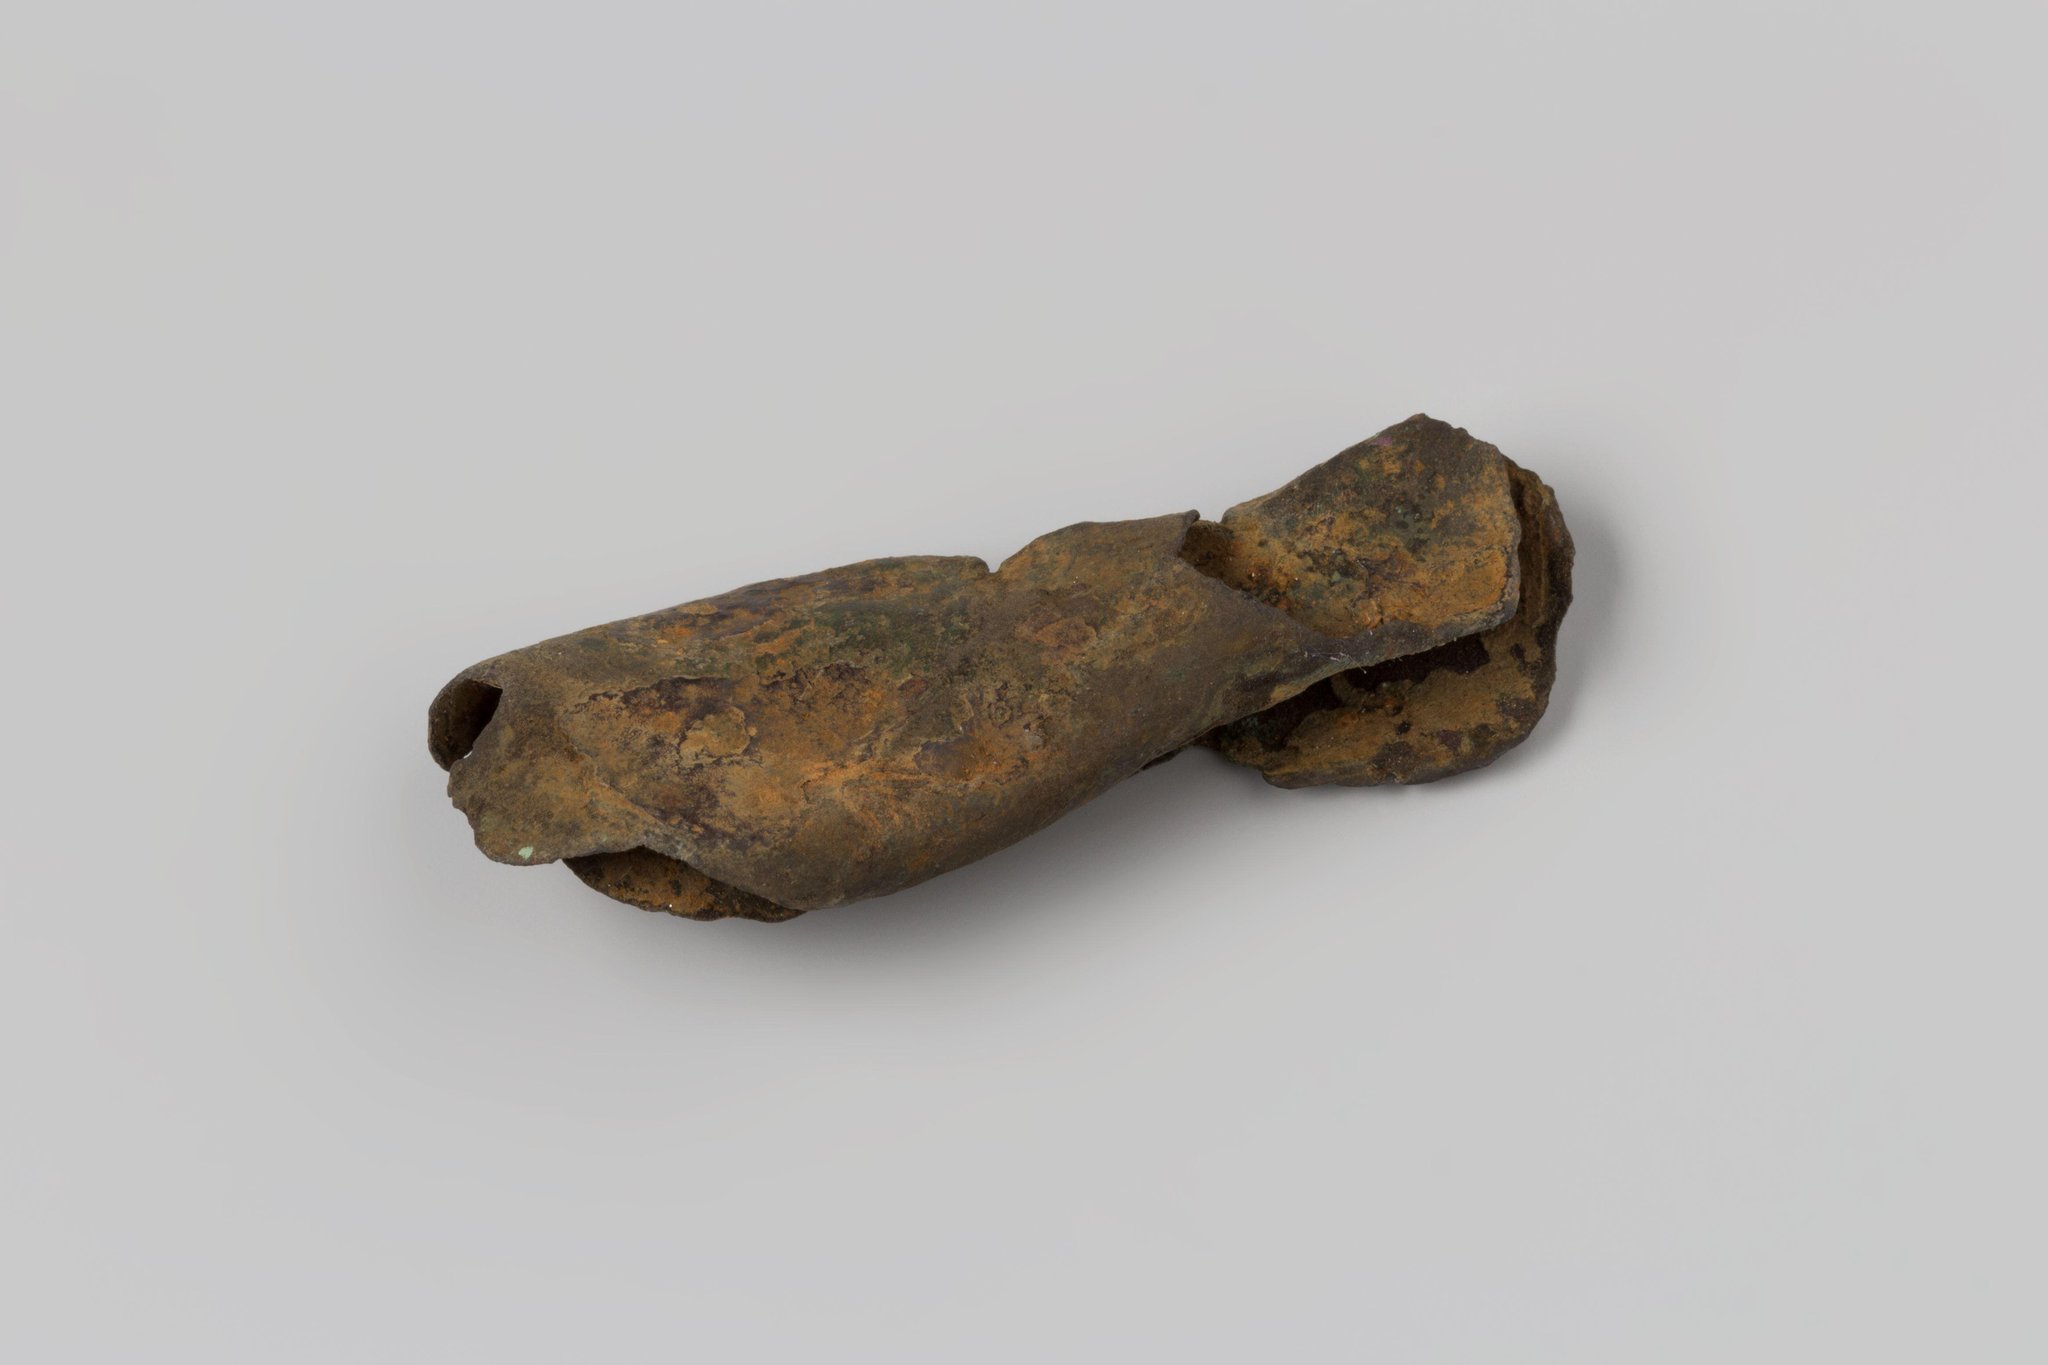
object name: scheepswrakvondst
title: Fragment van koper uit het wrak van de Oost-Indiëvaarder Hollandia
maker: Anonymous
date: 1700-1743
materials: copper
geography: netherlands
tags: verenigde oostindische compagnie, hollandia (schip), annet